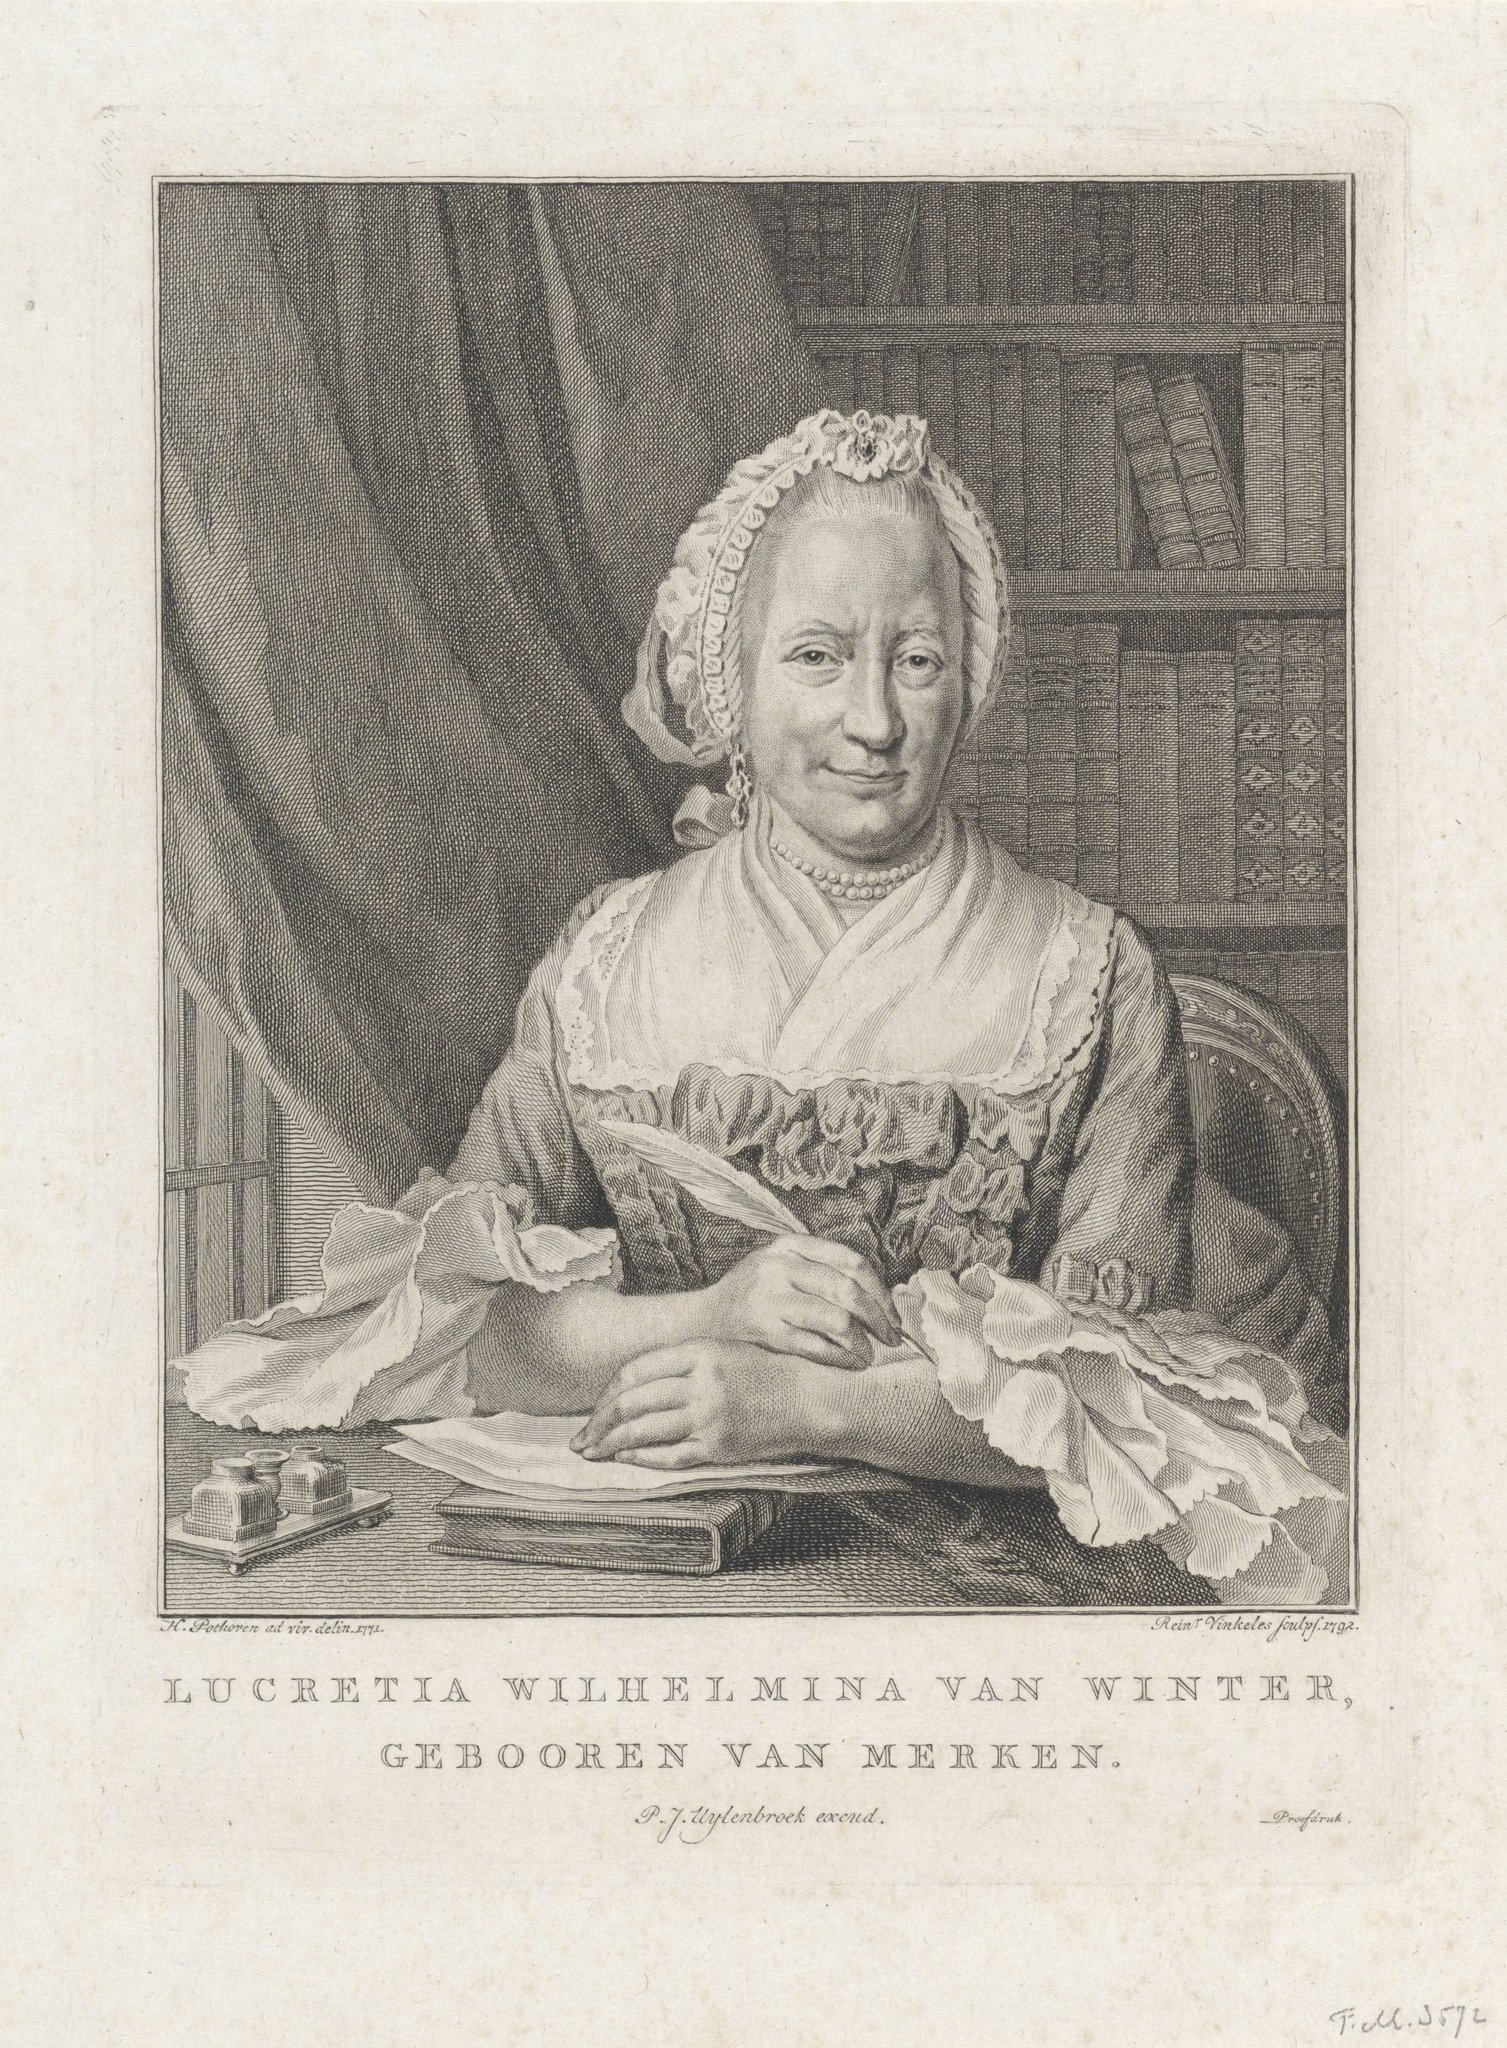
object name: print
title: Portret van Lucretia Wilhelmina van Merken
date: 1792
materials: paper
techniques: engraving, etching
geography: amsterdam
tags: amsterdam, leiden, lucretia wilhelmina van merken, quill, ink-well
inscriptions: collector's mark: Lugt 2228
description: Portret van de Nederlandse dichteres Lucretia Wilhelmina van Merken, zittend voor een tafel met voor haar inktpot, een boek en een vel papier, in haar hand een schrijfveer.